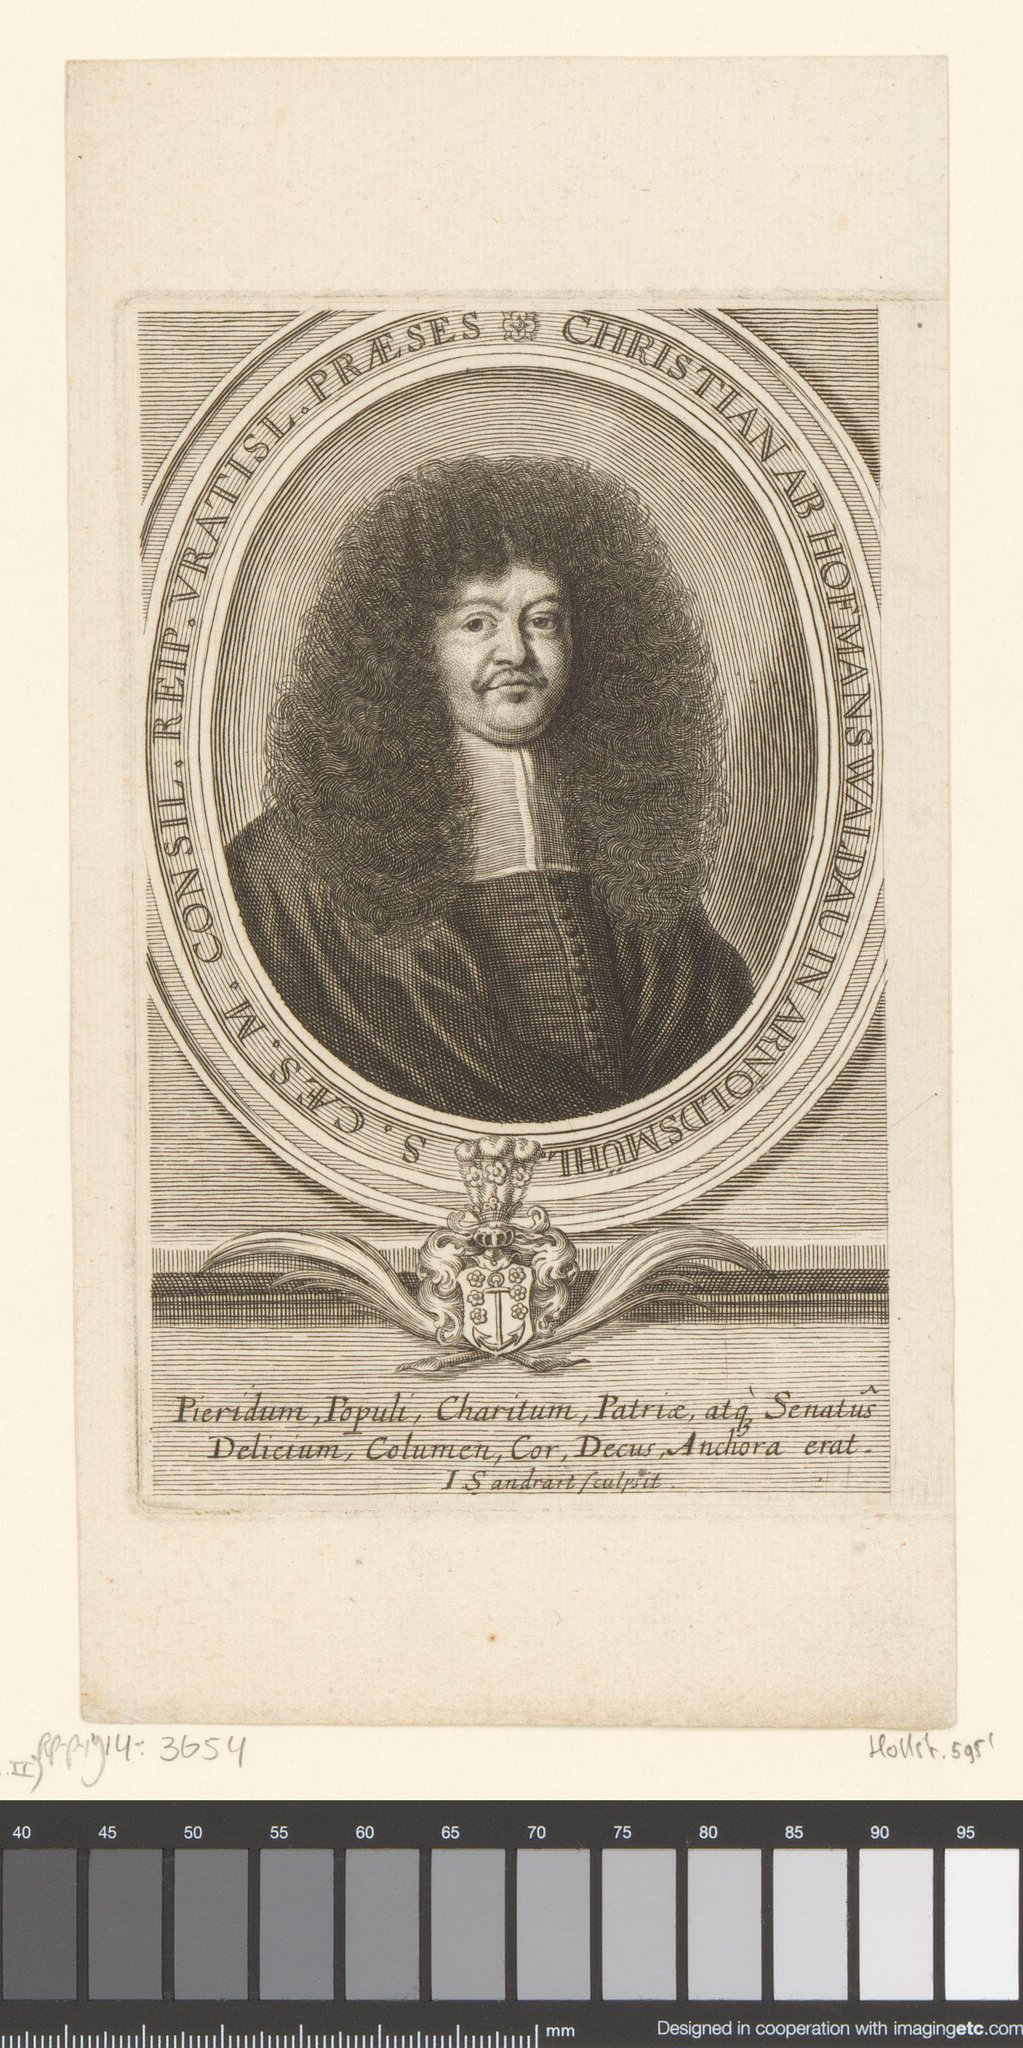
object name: print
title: Portret van Christian Hofmann von Hofmannswaldau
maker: jakob von sandrart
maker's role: print maker, publisher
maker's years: 1630-1708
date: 1679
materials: paper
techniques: engraving, etching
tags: historical persons, writer, poet, author, armorial bearing, heraldry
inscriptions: collector's mark: Lugt 2228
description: Prent ook gebruikt in: Lohenstein, D.C. von. Lob-Rede. Wroclaw: Esaias Fellgiebel, 1679.